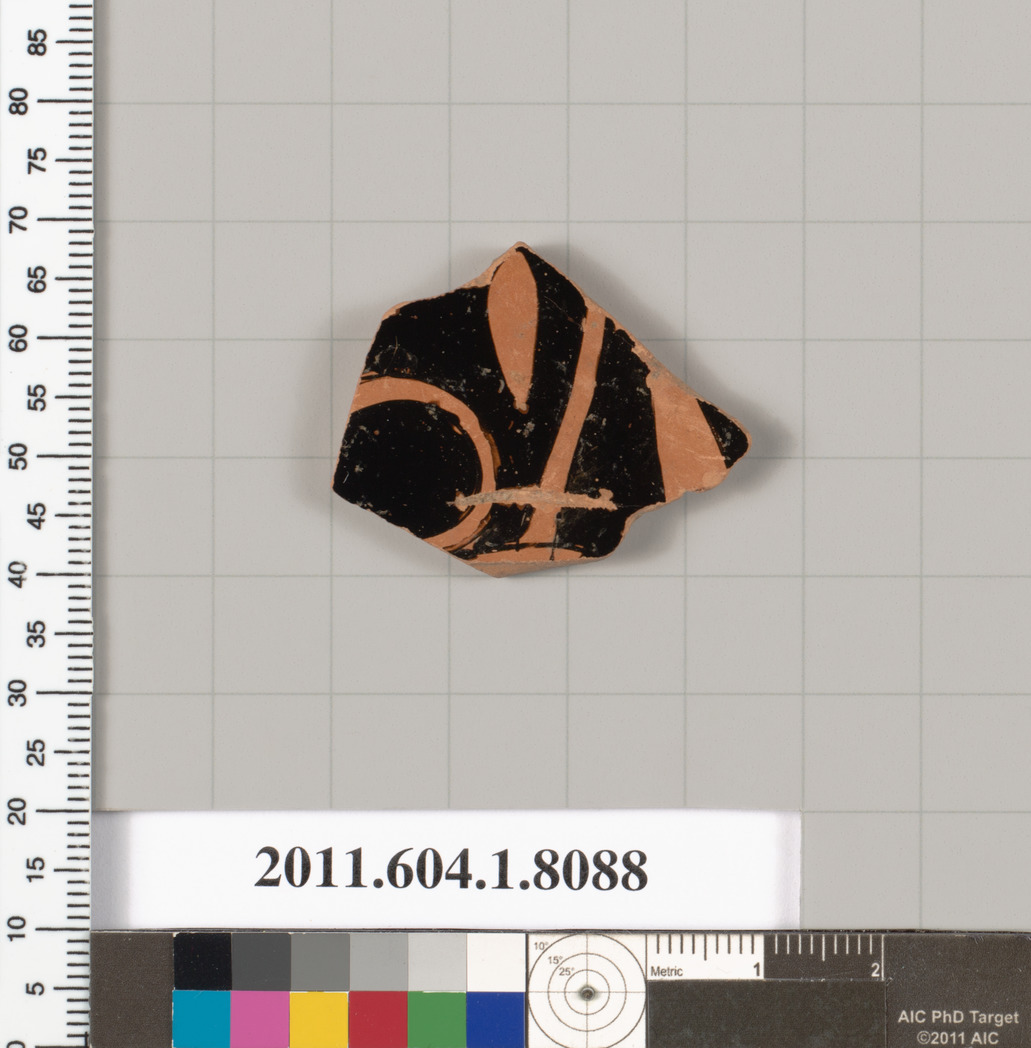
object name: kylix fragment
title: Terracotta fragment of a kylix (drinking cup)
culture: greek, attic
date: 467-435 BCE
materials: terracotta